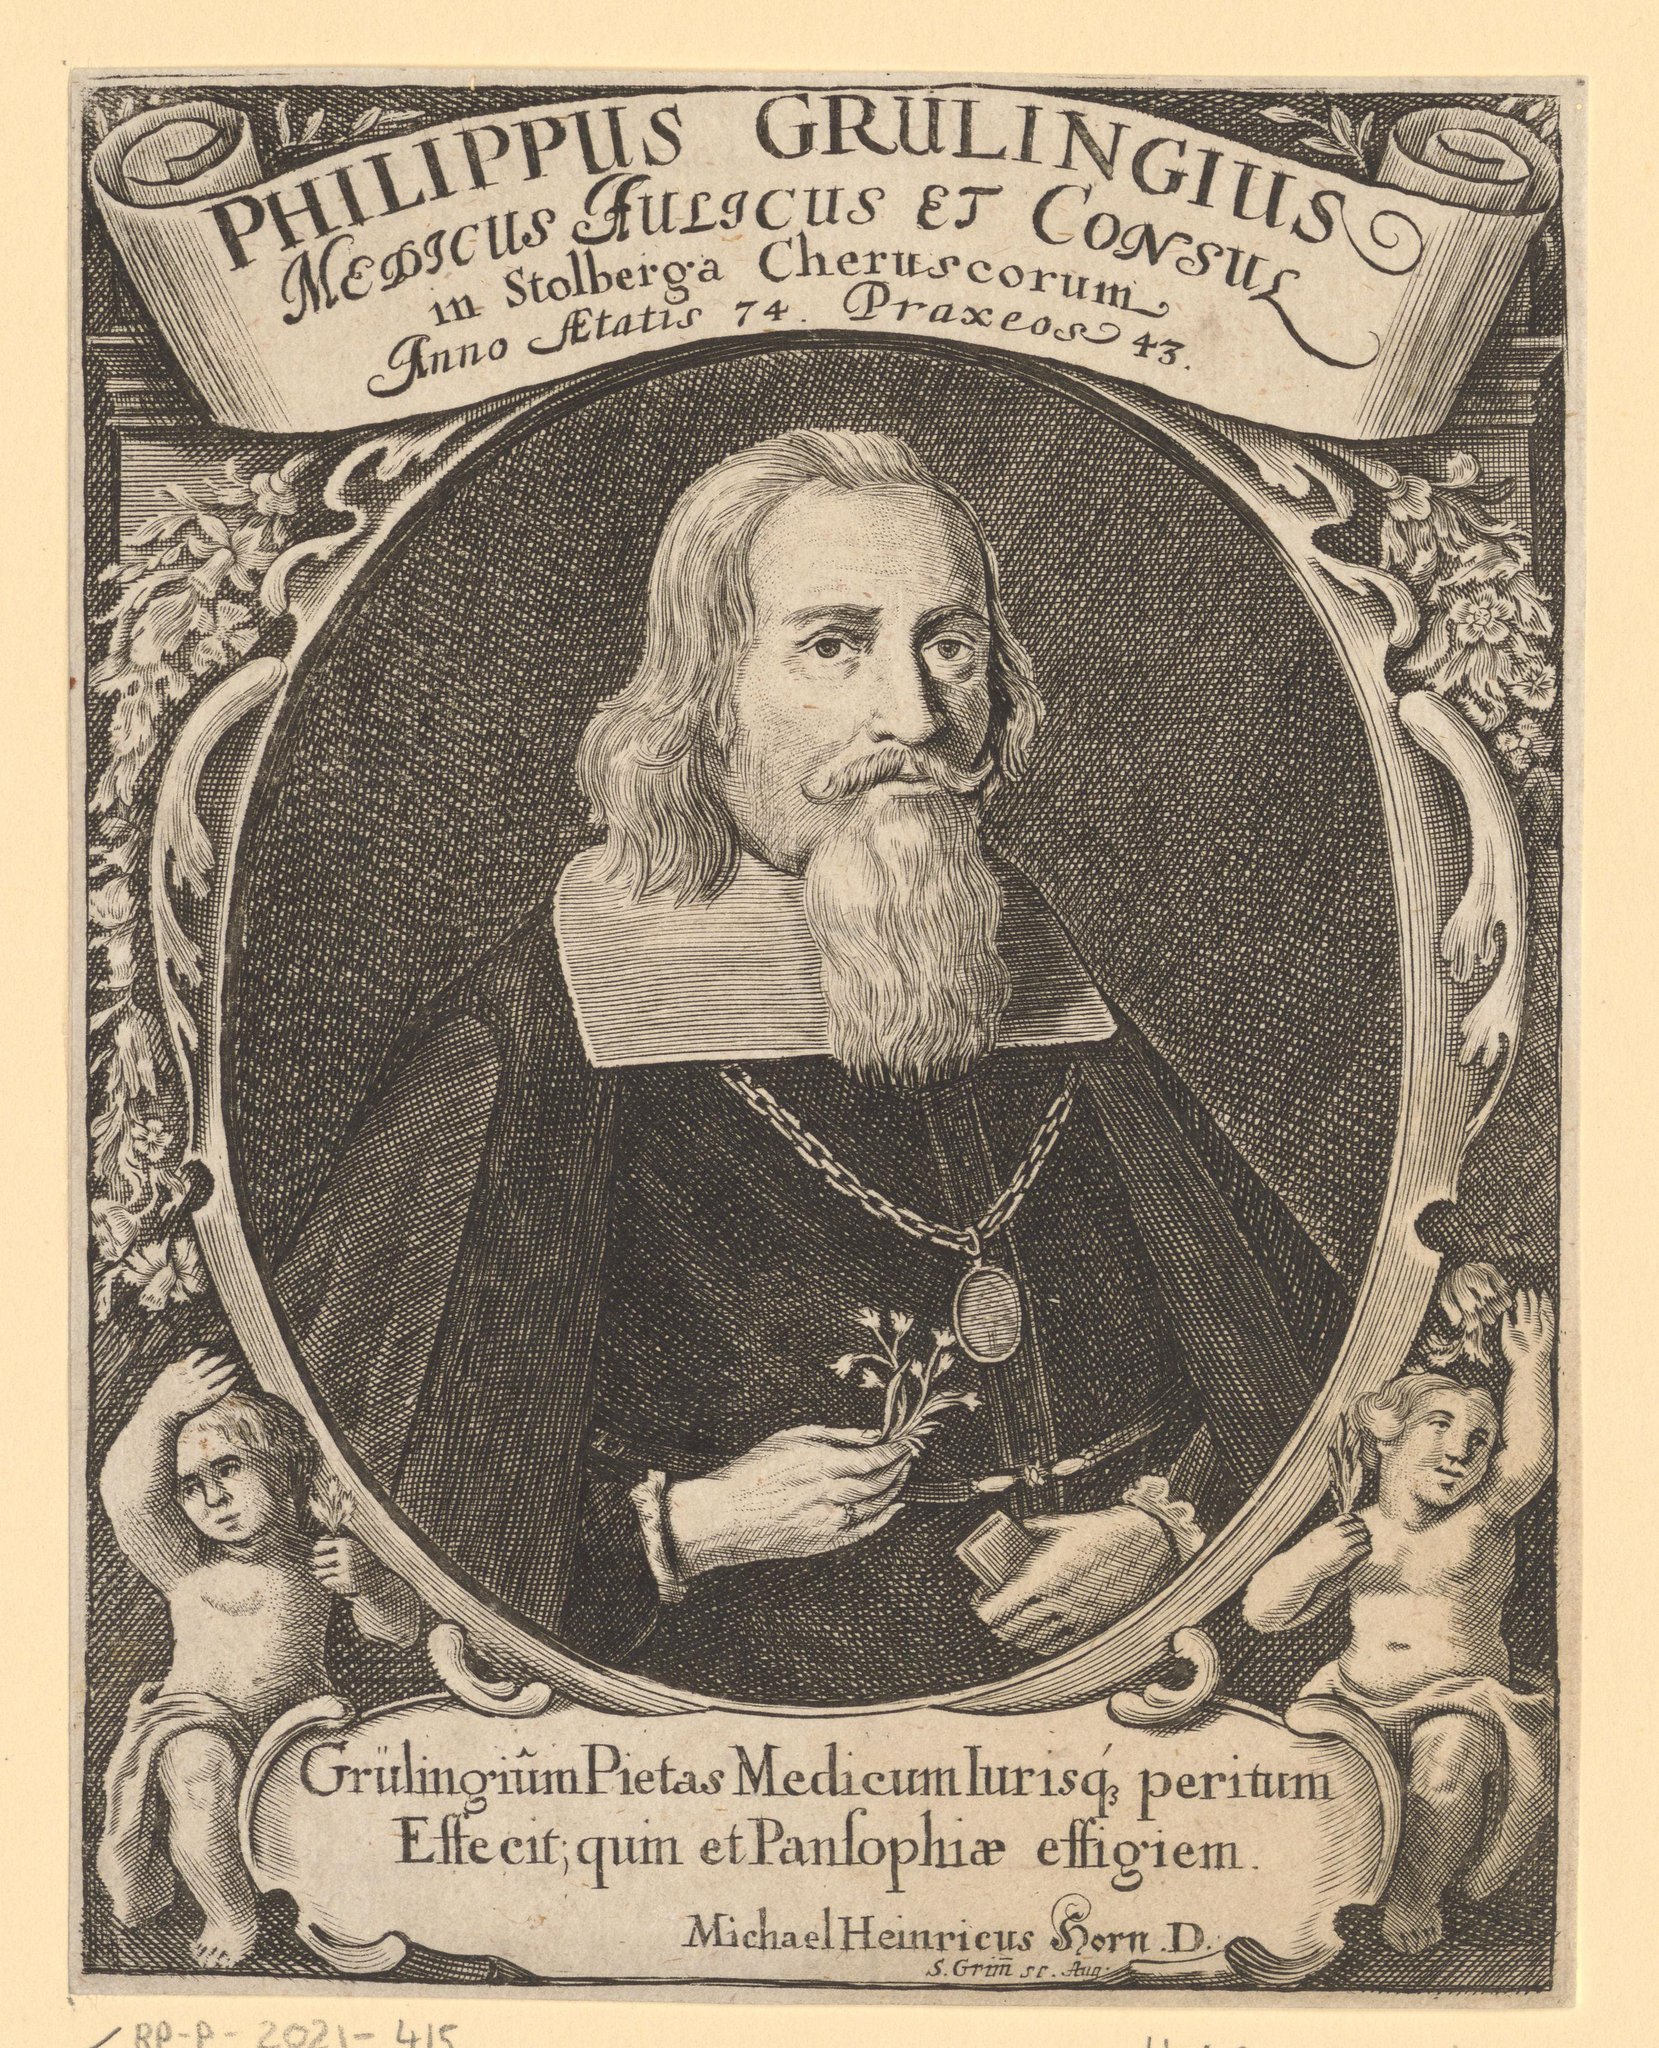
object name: print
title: Portret van Philipp Gerhard Grueling op 74-jarige leeftijd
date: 1667-1682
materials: paper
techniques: engraving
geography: augsburg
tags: historical persons, physician, doctor, cupids: 'amores', 'amoretti', 'putti'